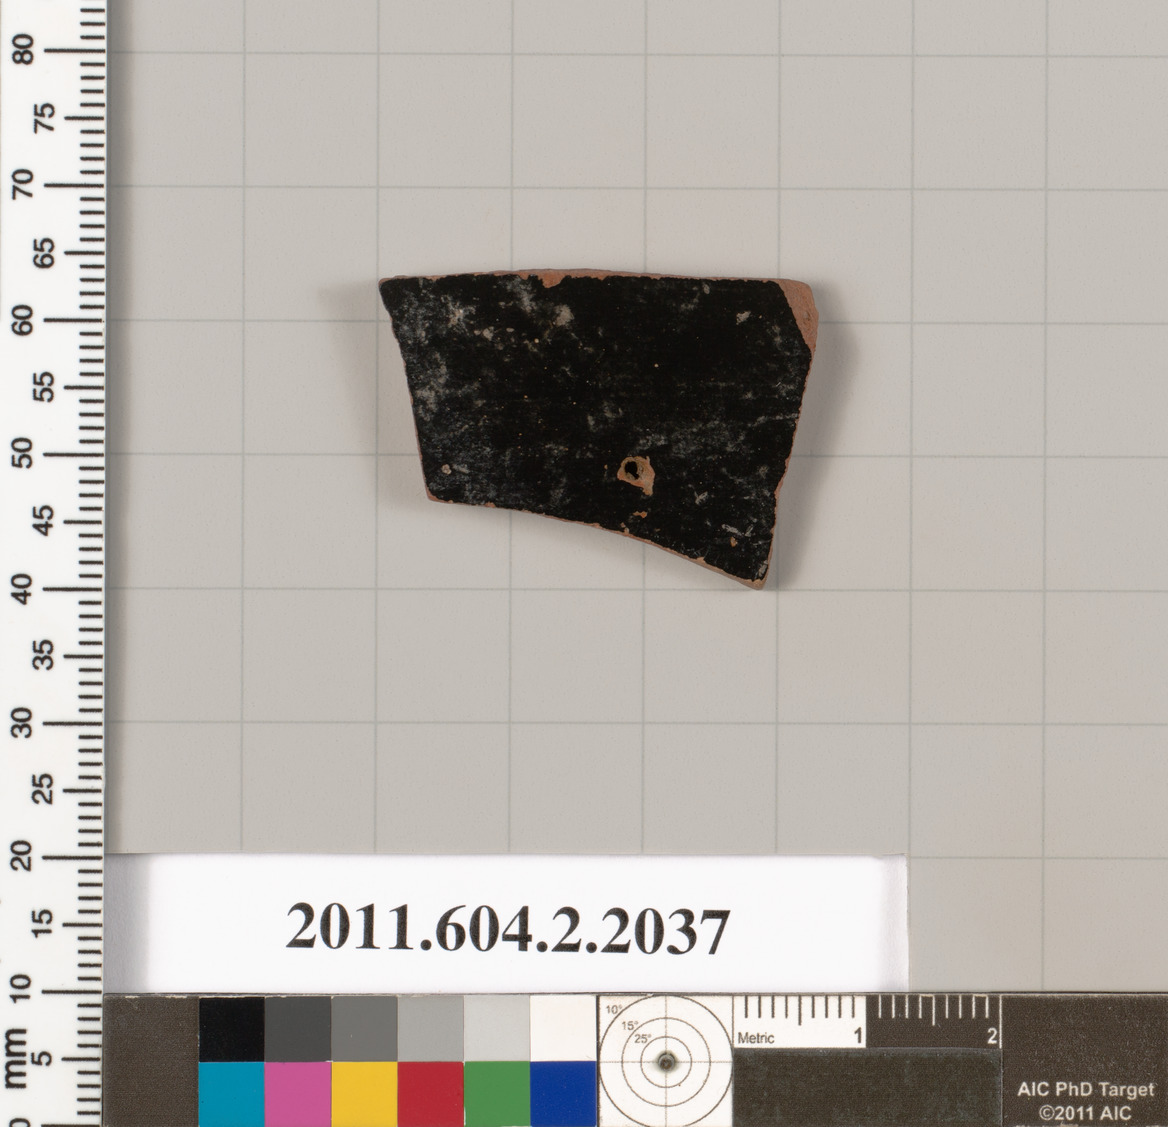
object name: pot fragment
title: Terracotta fragment of a pot; glazed on the inside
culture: greek, attic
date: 600-401 BCE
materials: terracotta